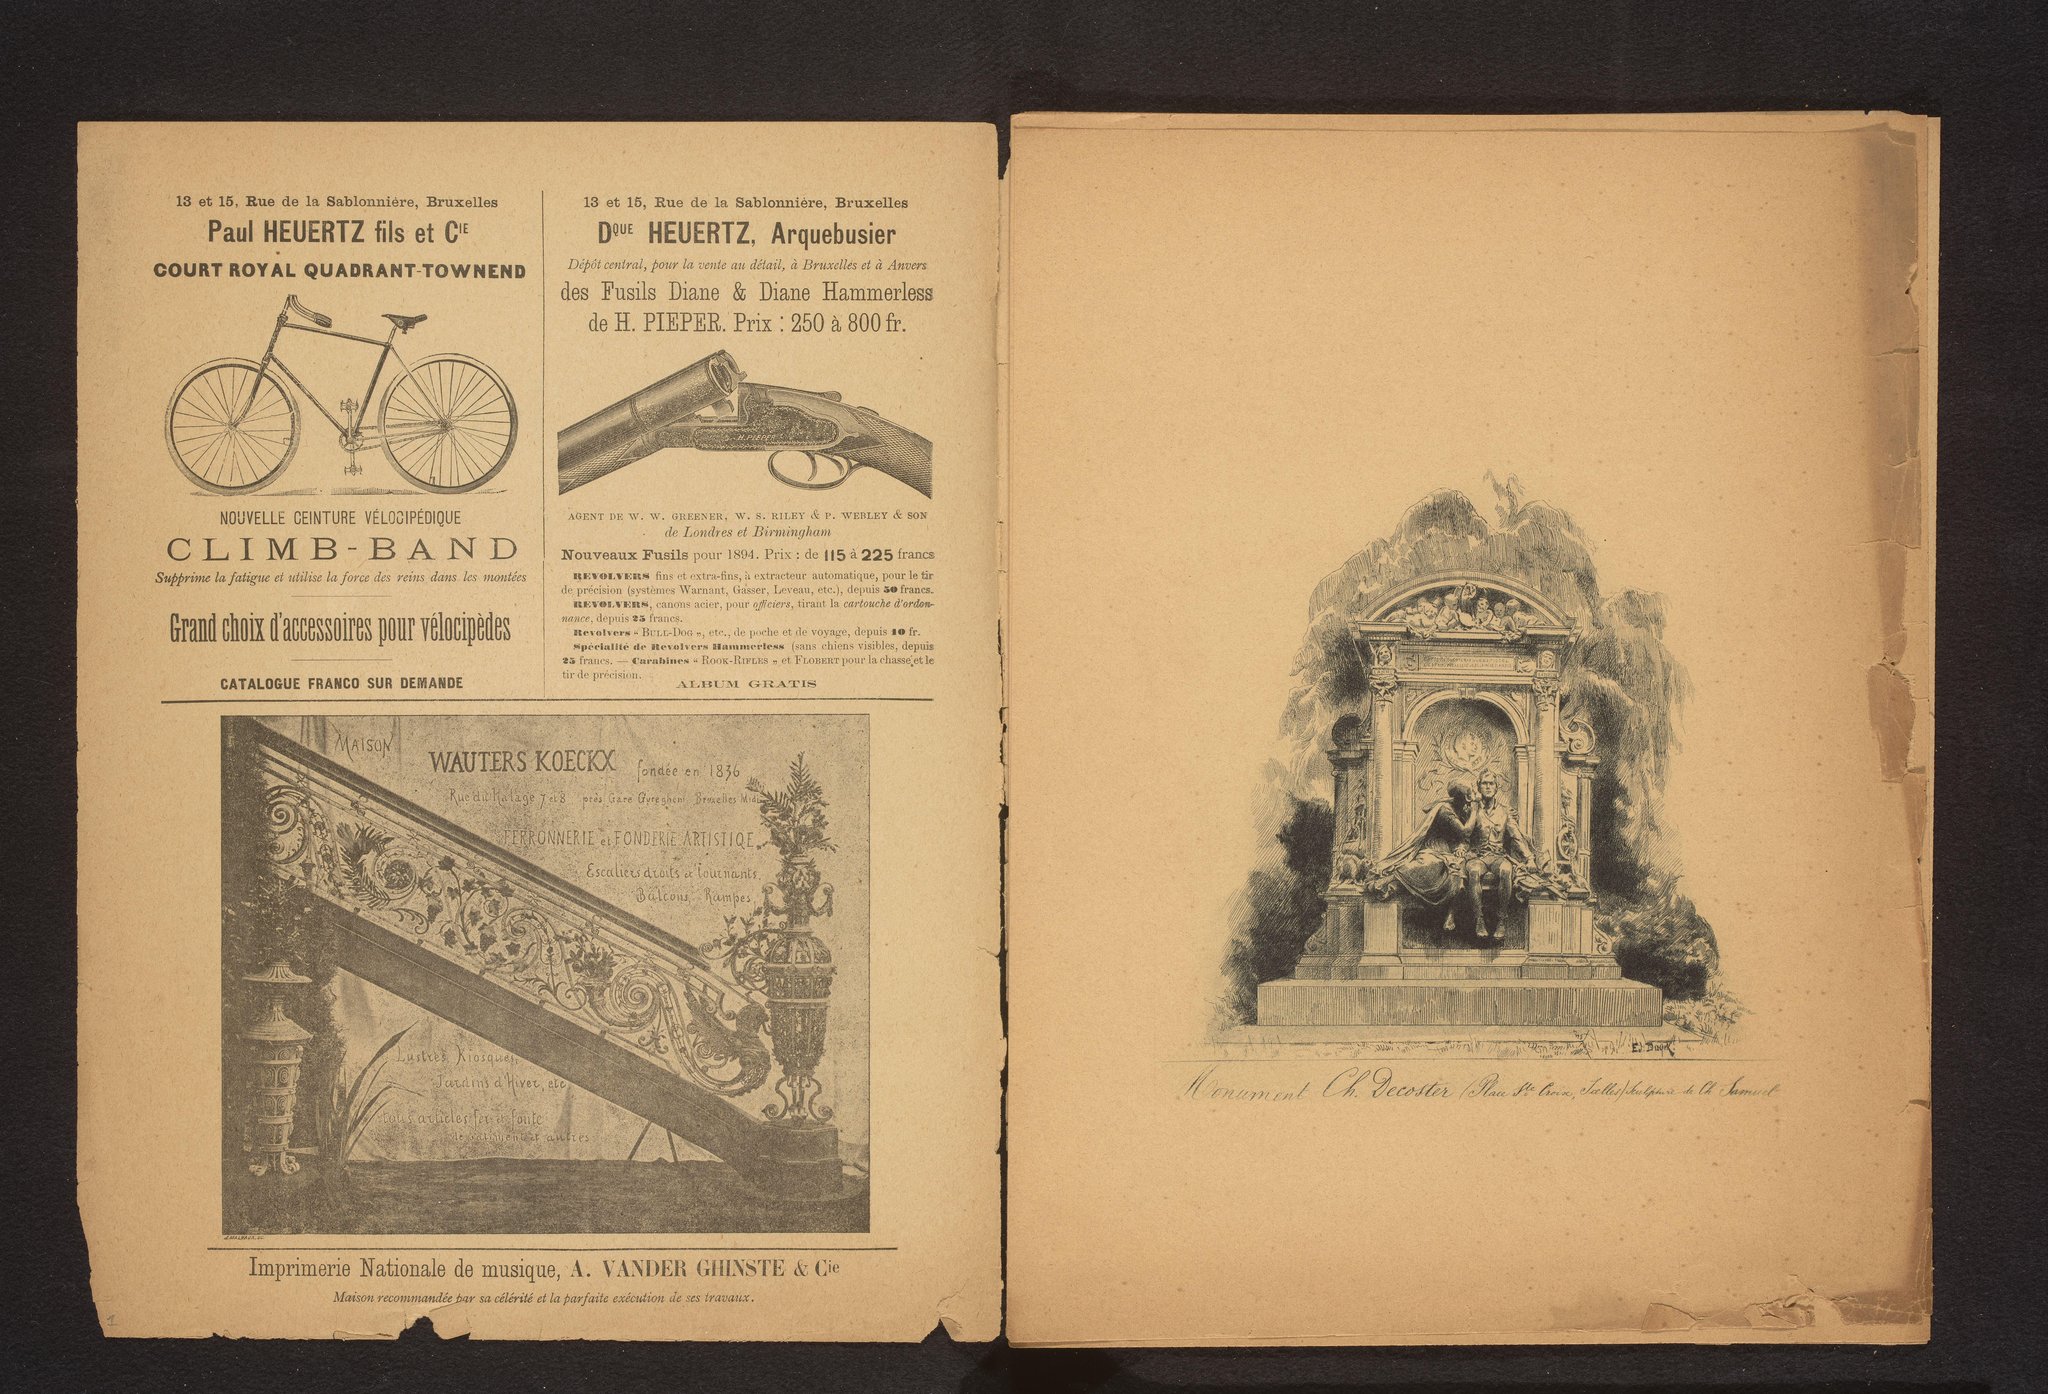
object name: book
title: La libre critique revue d'art et de littérature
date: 1894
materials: paper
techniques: photograph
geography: brussels